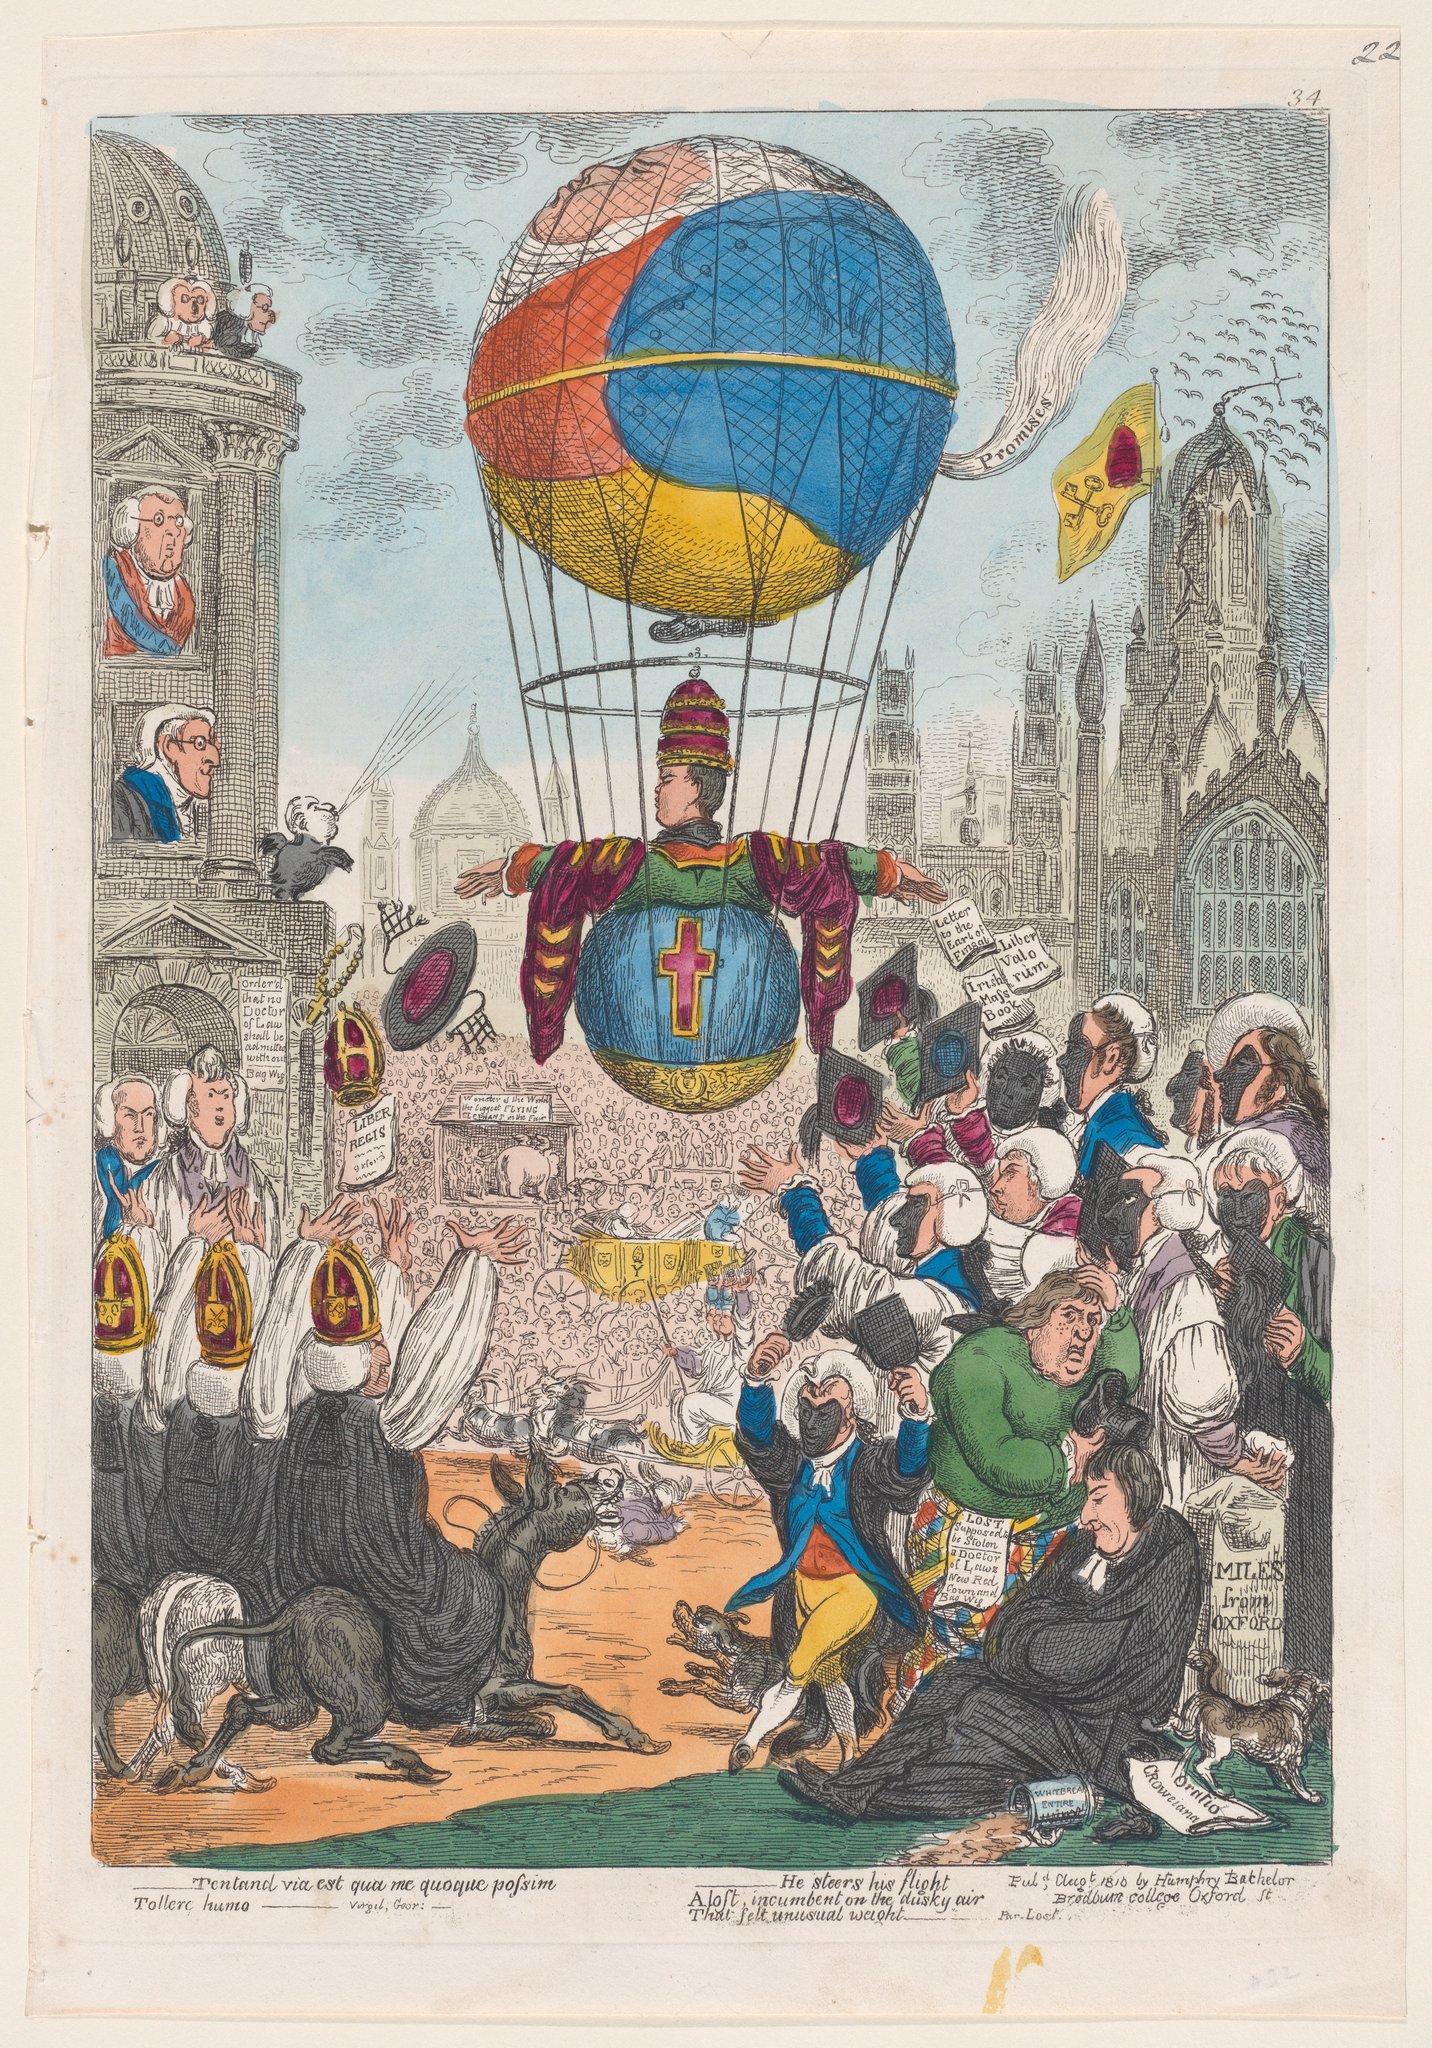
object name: print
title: Tendanda via est qua me quoque possim tollere humo–Virgil, Geor:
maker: james gillray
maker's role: artist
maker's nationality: british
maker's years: 1756-1815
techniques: etching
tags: men,dogs,donkeys,hot air balloons,caricature